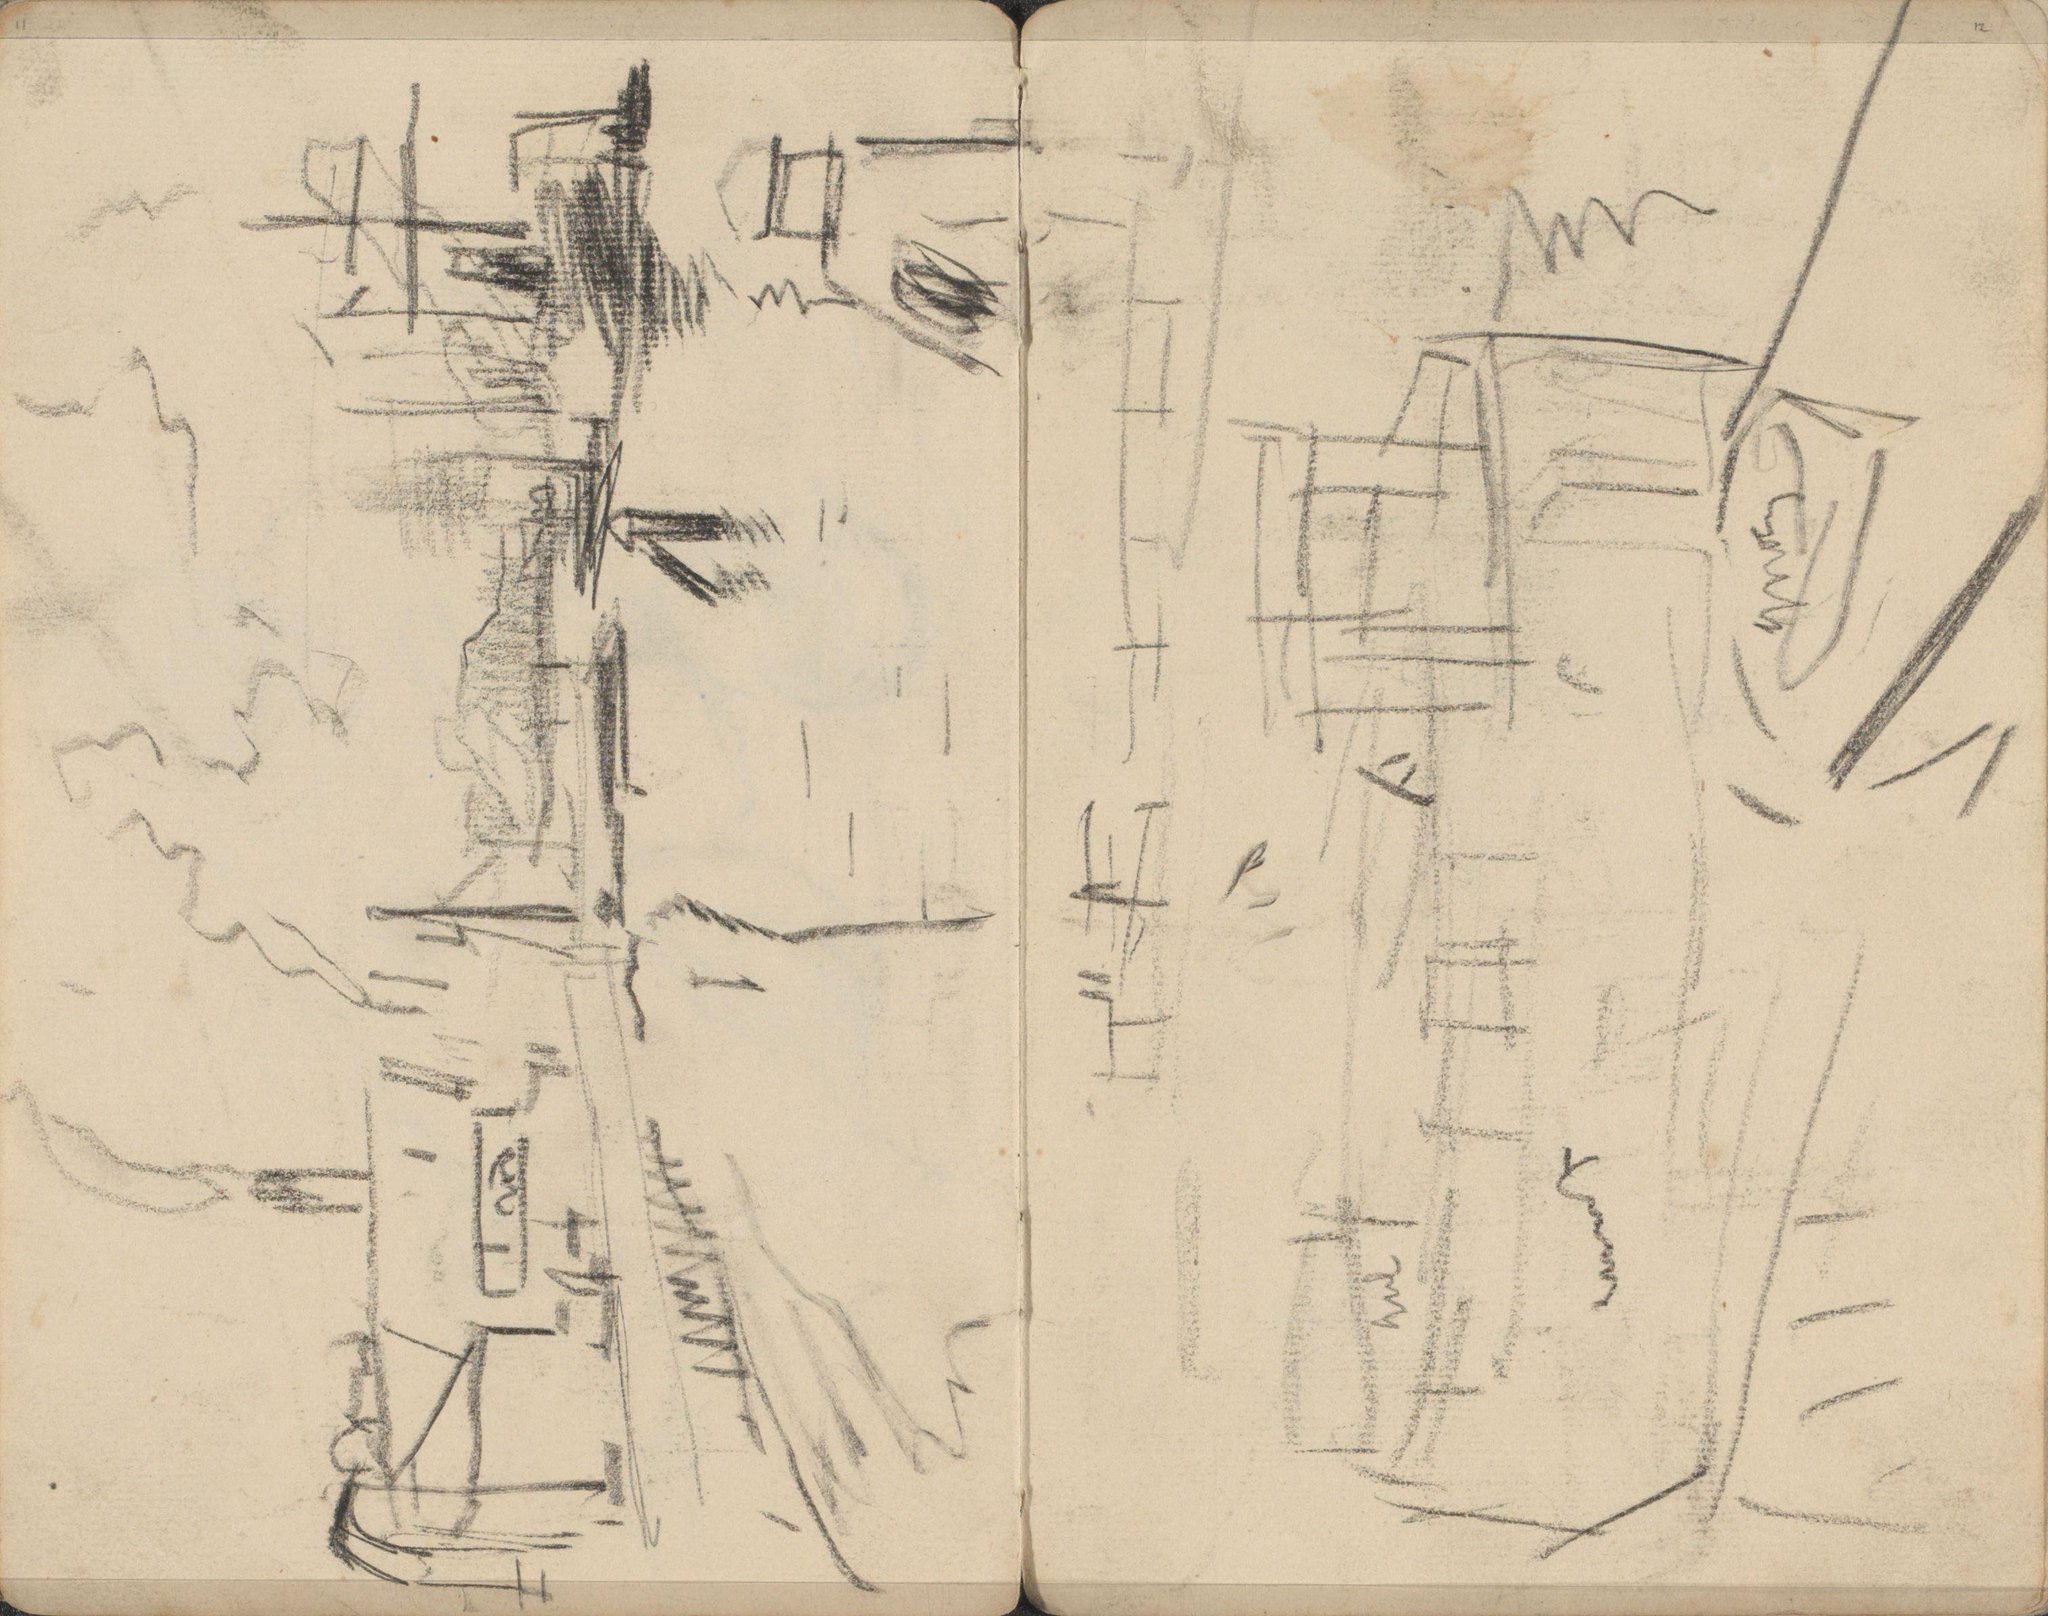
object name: sketchbook leaf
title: Gezicht in Amsterdam met aangemeerde schepen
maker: george hendrik breitner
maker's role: draughtsman, painter, print maker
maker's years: 1857-1923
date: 1867-1923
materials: chalk, paper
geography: amsterdam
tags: factory-building, ships (in general), canals, waters (in city), amsterdam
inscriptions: kleurnotitie, handgeschreven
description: Op de achtergrond rokende schoorstenen. Pagina 11 en pagina 12 uit een schetsboek met 10 bladen.